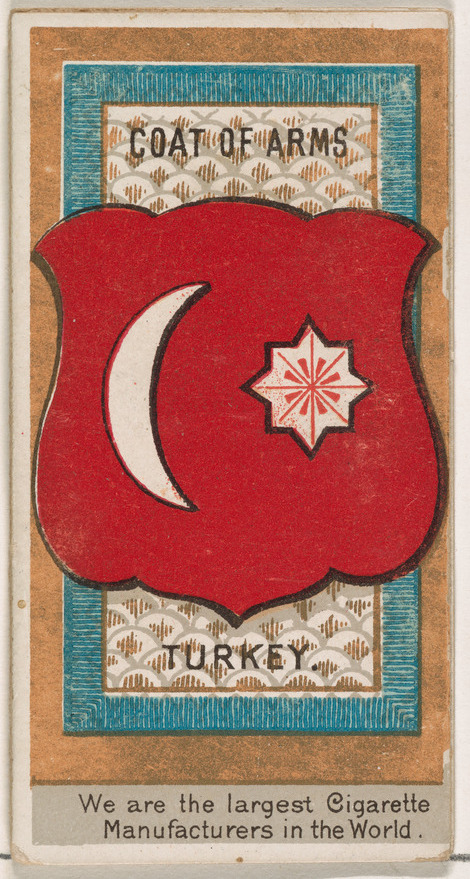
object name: print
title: Abdul Hamid, Sultan of Turkey, from the Rulers, Flags, and Coats of Arms series (N126-2) issued by W. Duke, Sons & Co.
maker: w. duke, sons & co.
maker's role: publisher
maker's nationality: american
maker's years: 1870-1920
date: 1888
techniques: color lithograph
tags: coat of arms